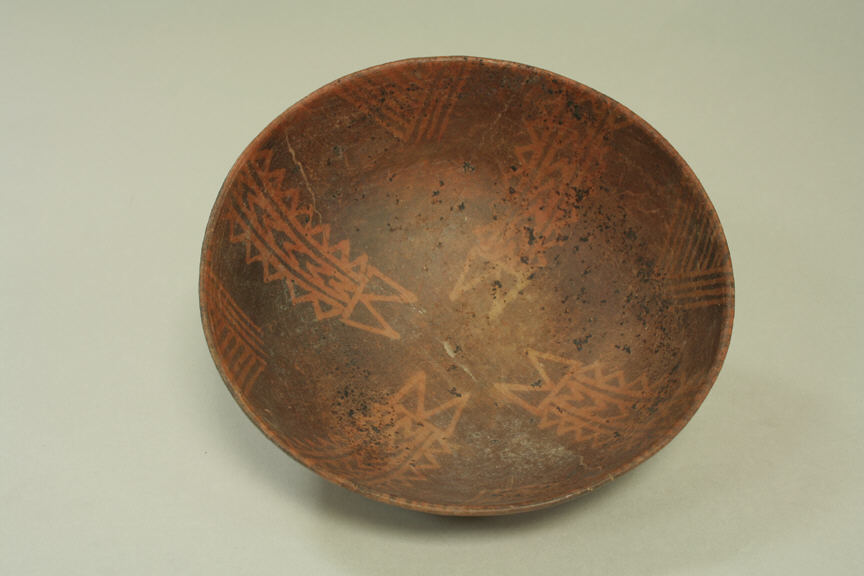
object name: bowl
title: Bowl with Geometric Patterns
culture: paracas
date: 500-100 BCE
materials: ceramic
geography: peru